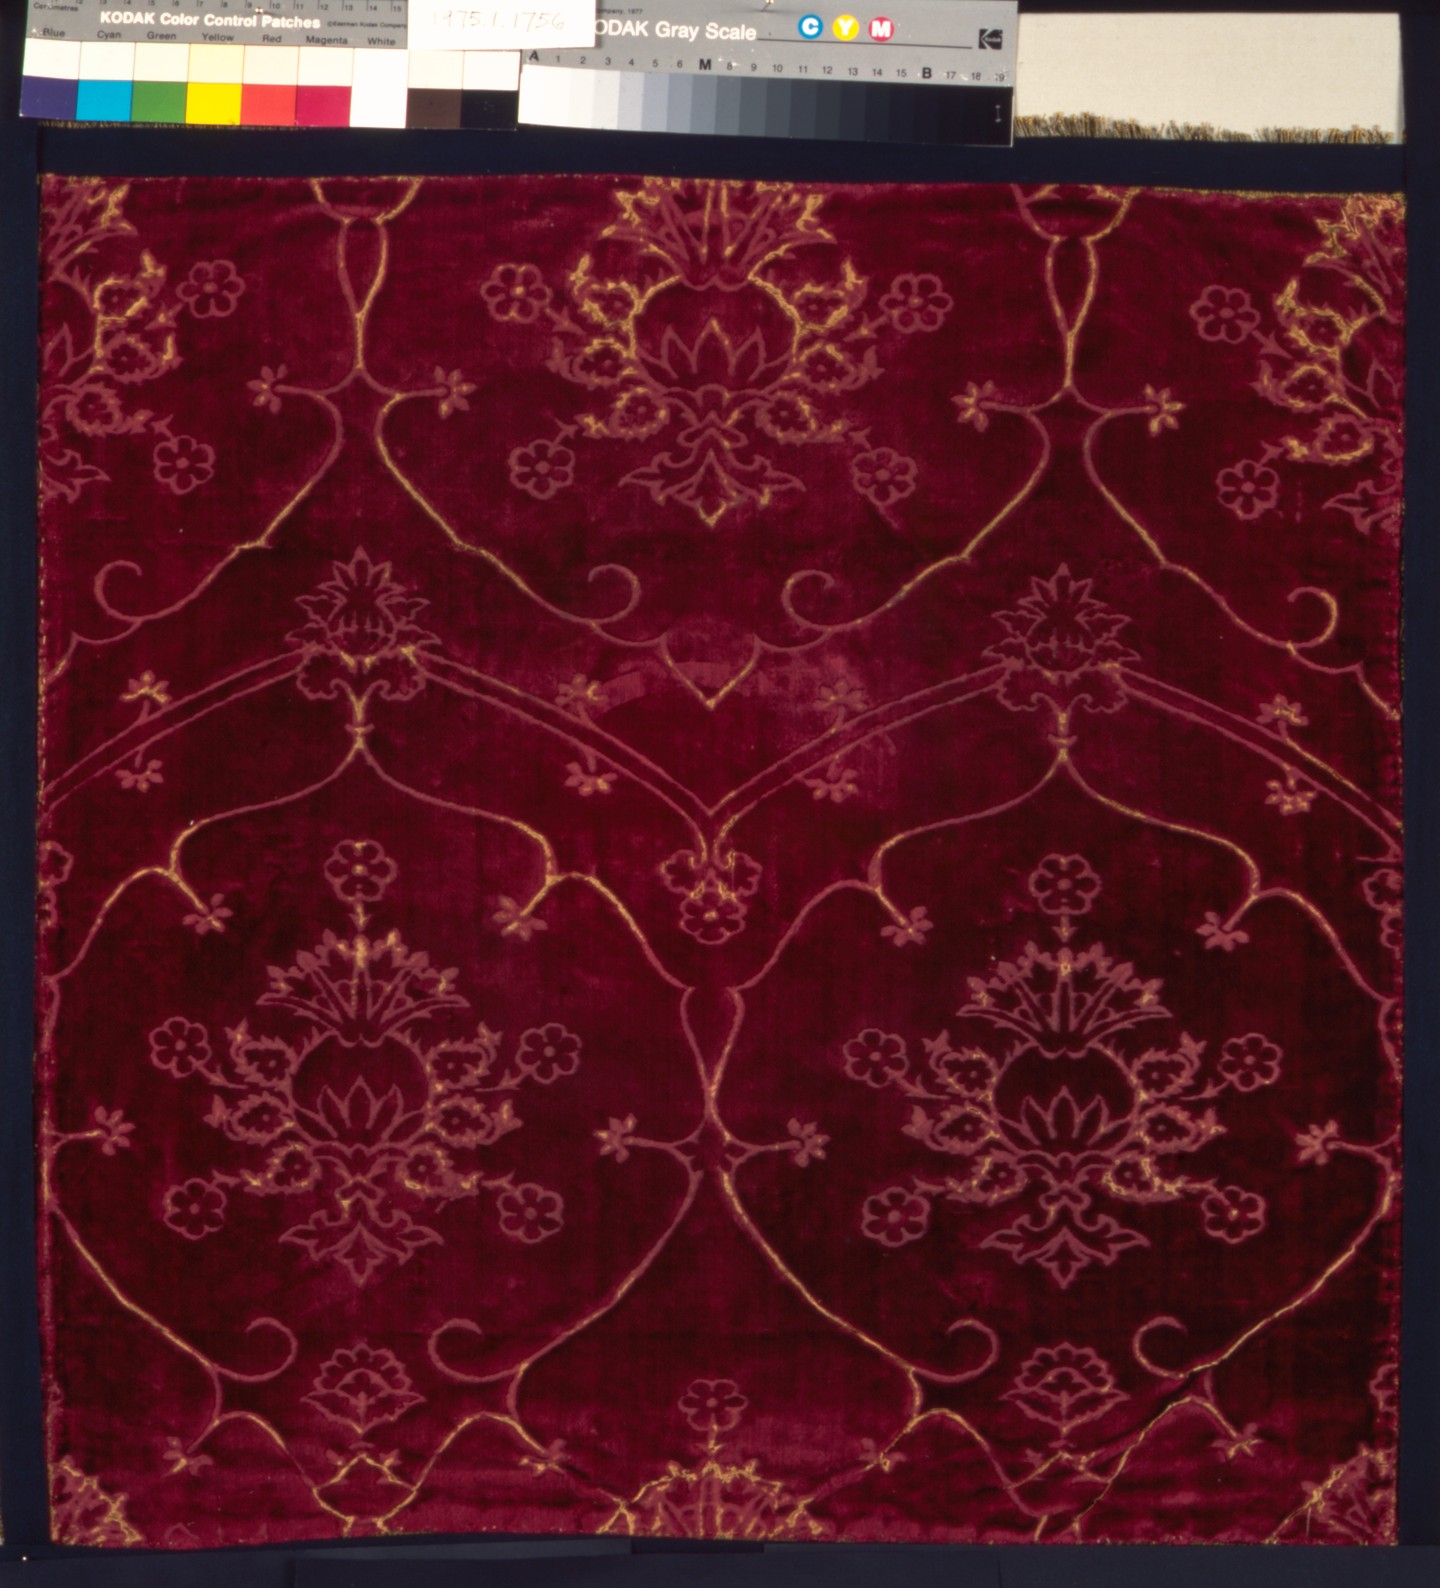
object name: textile cover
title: Cover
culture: italian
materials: metal, silk